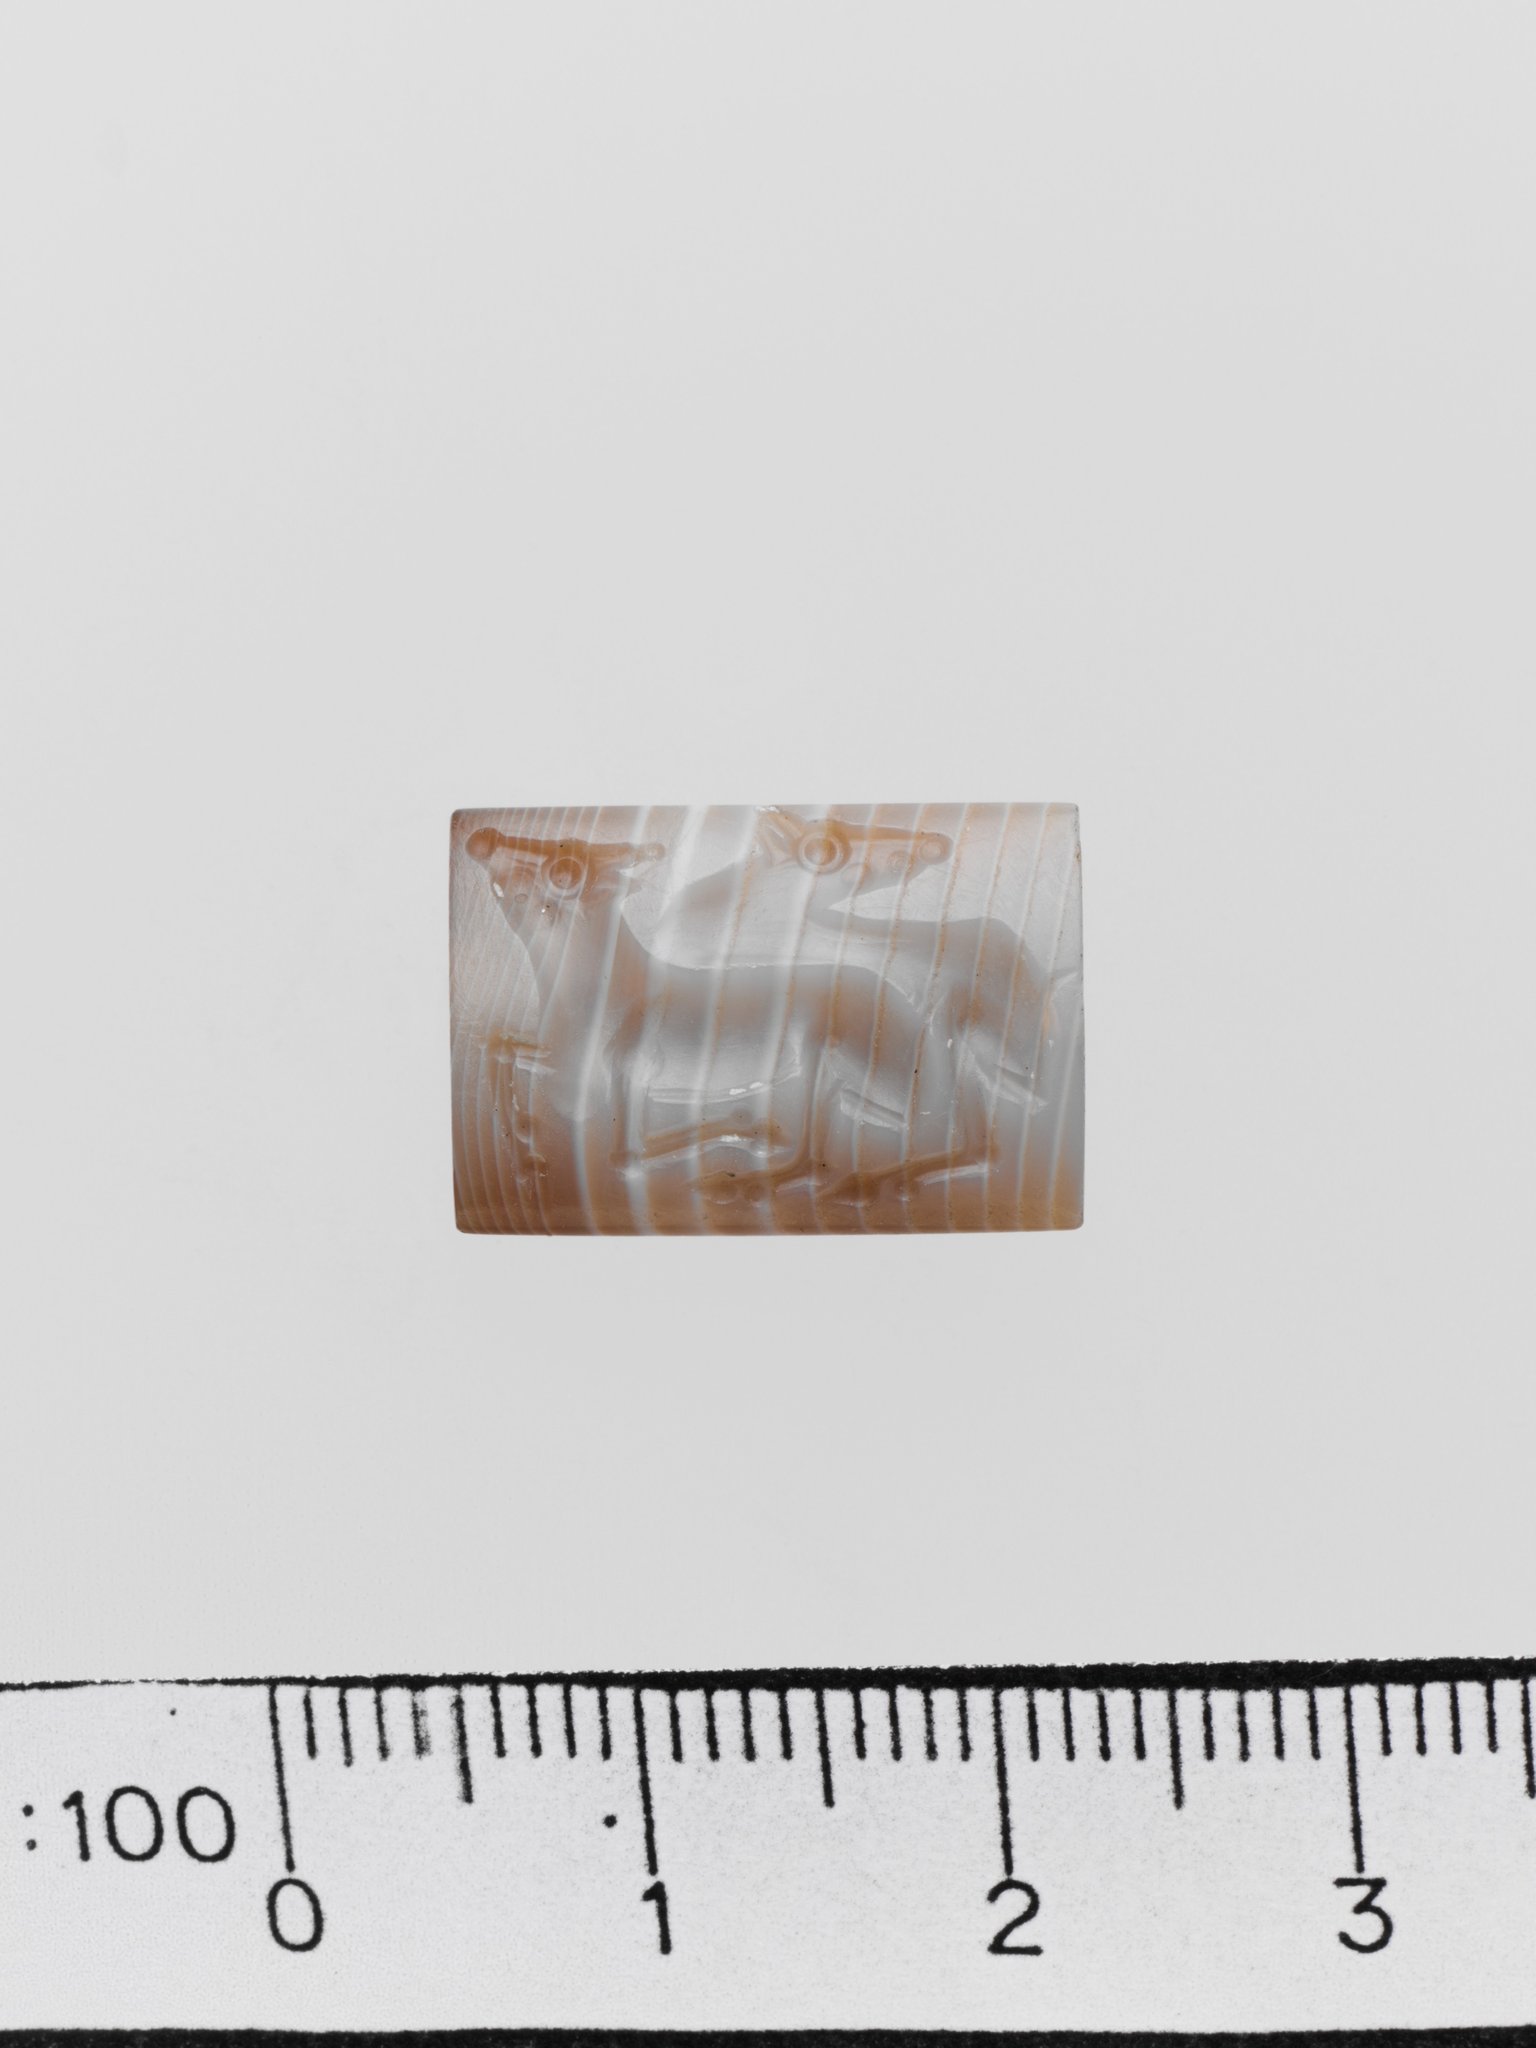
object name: seal, cushion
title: Banded agate cushion-shaped seal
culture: minoan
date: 1400-1300 BCE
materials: stone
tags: cows